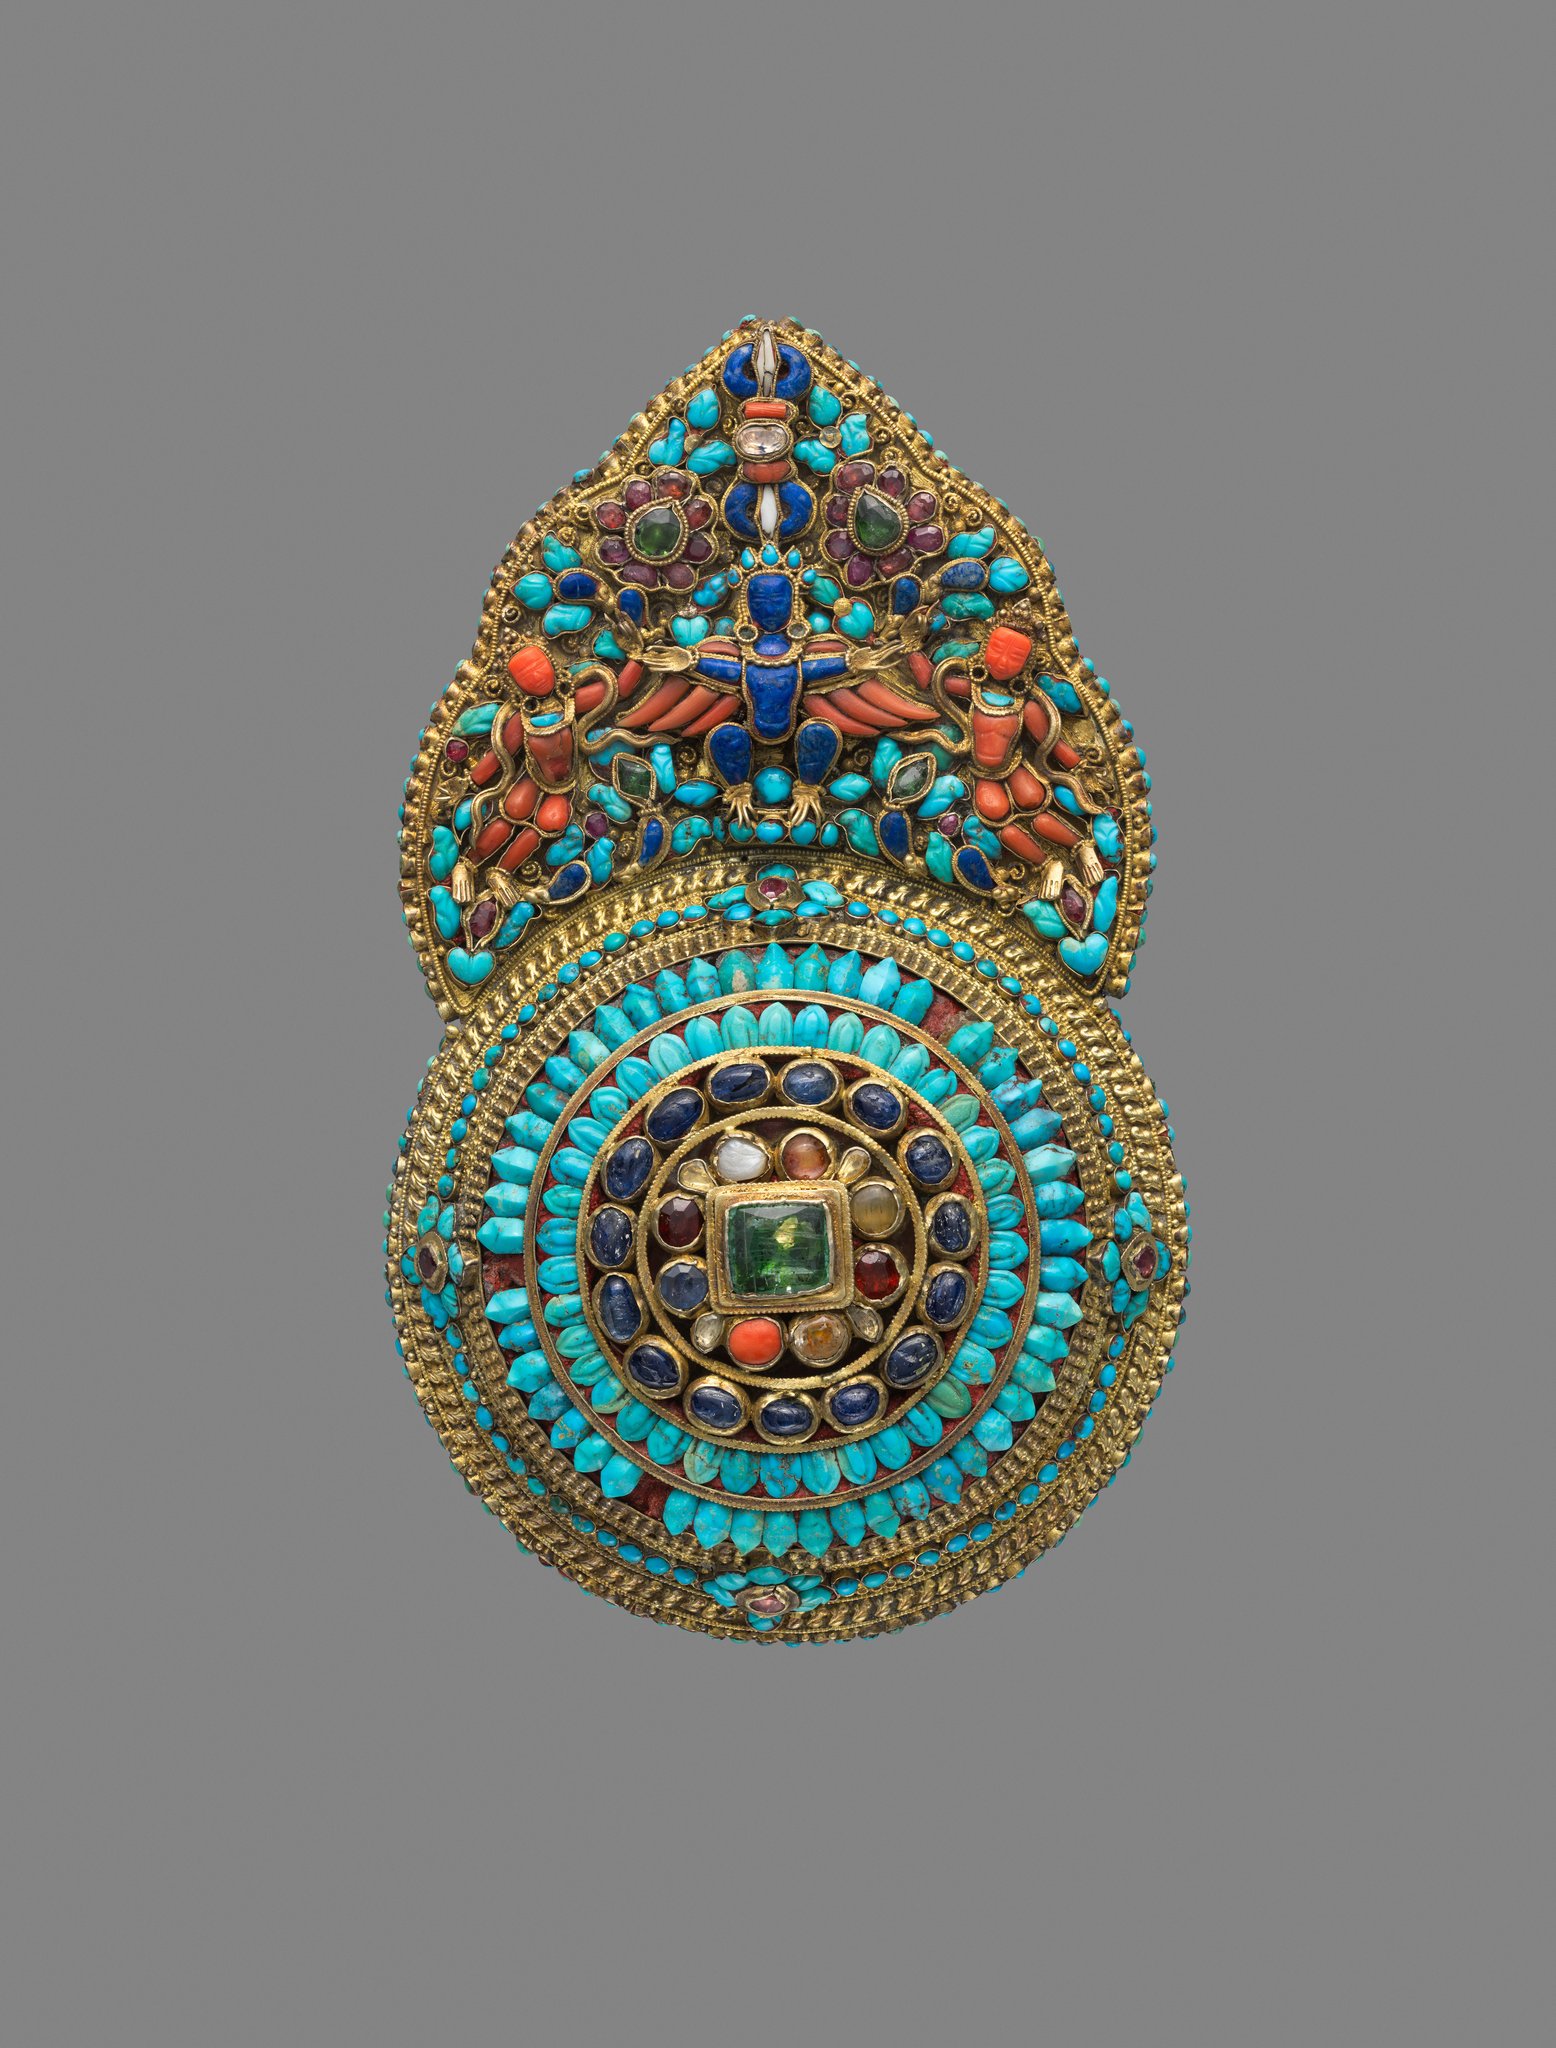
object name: ornament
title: Crown Ornament for a Deity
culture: newari or tibetan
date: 1601-1900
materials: amber, coral, gemstone, garnet, silver gilt, lapis lazuli, mother of pearl, pearl, shell